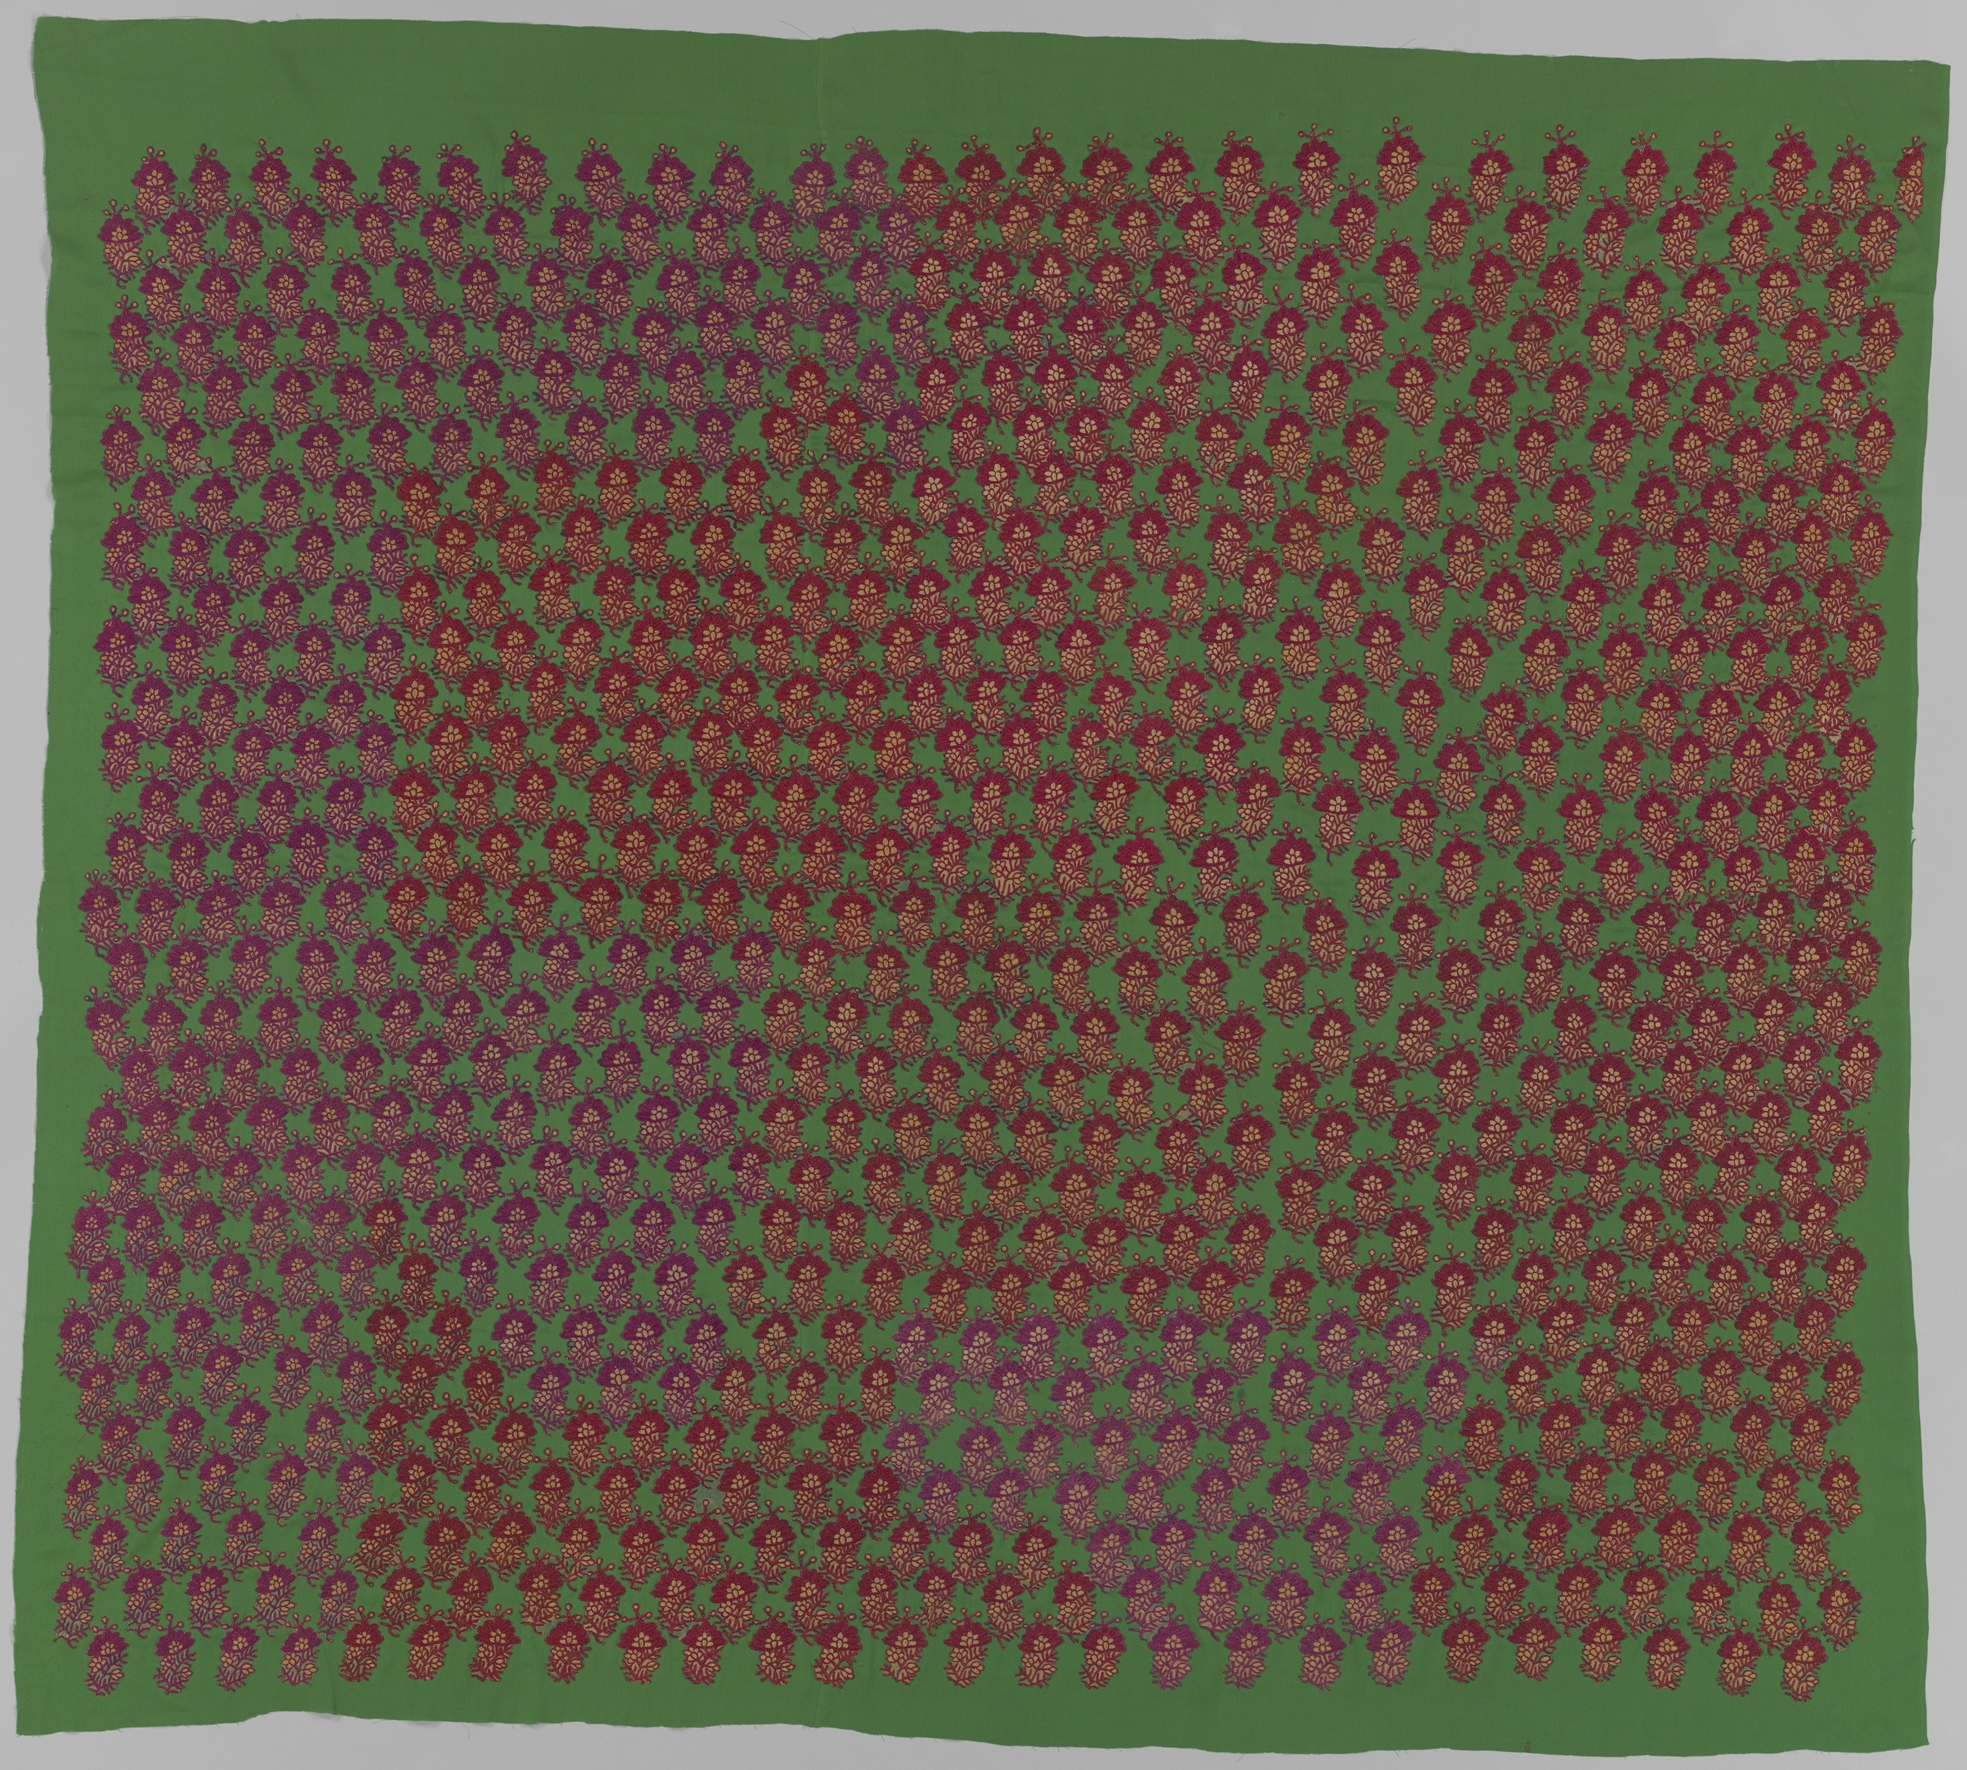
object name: fabric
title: Panel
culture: indian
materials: silk